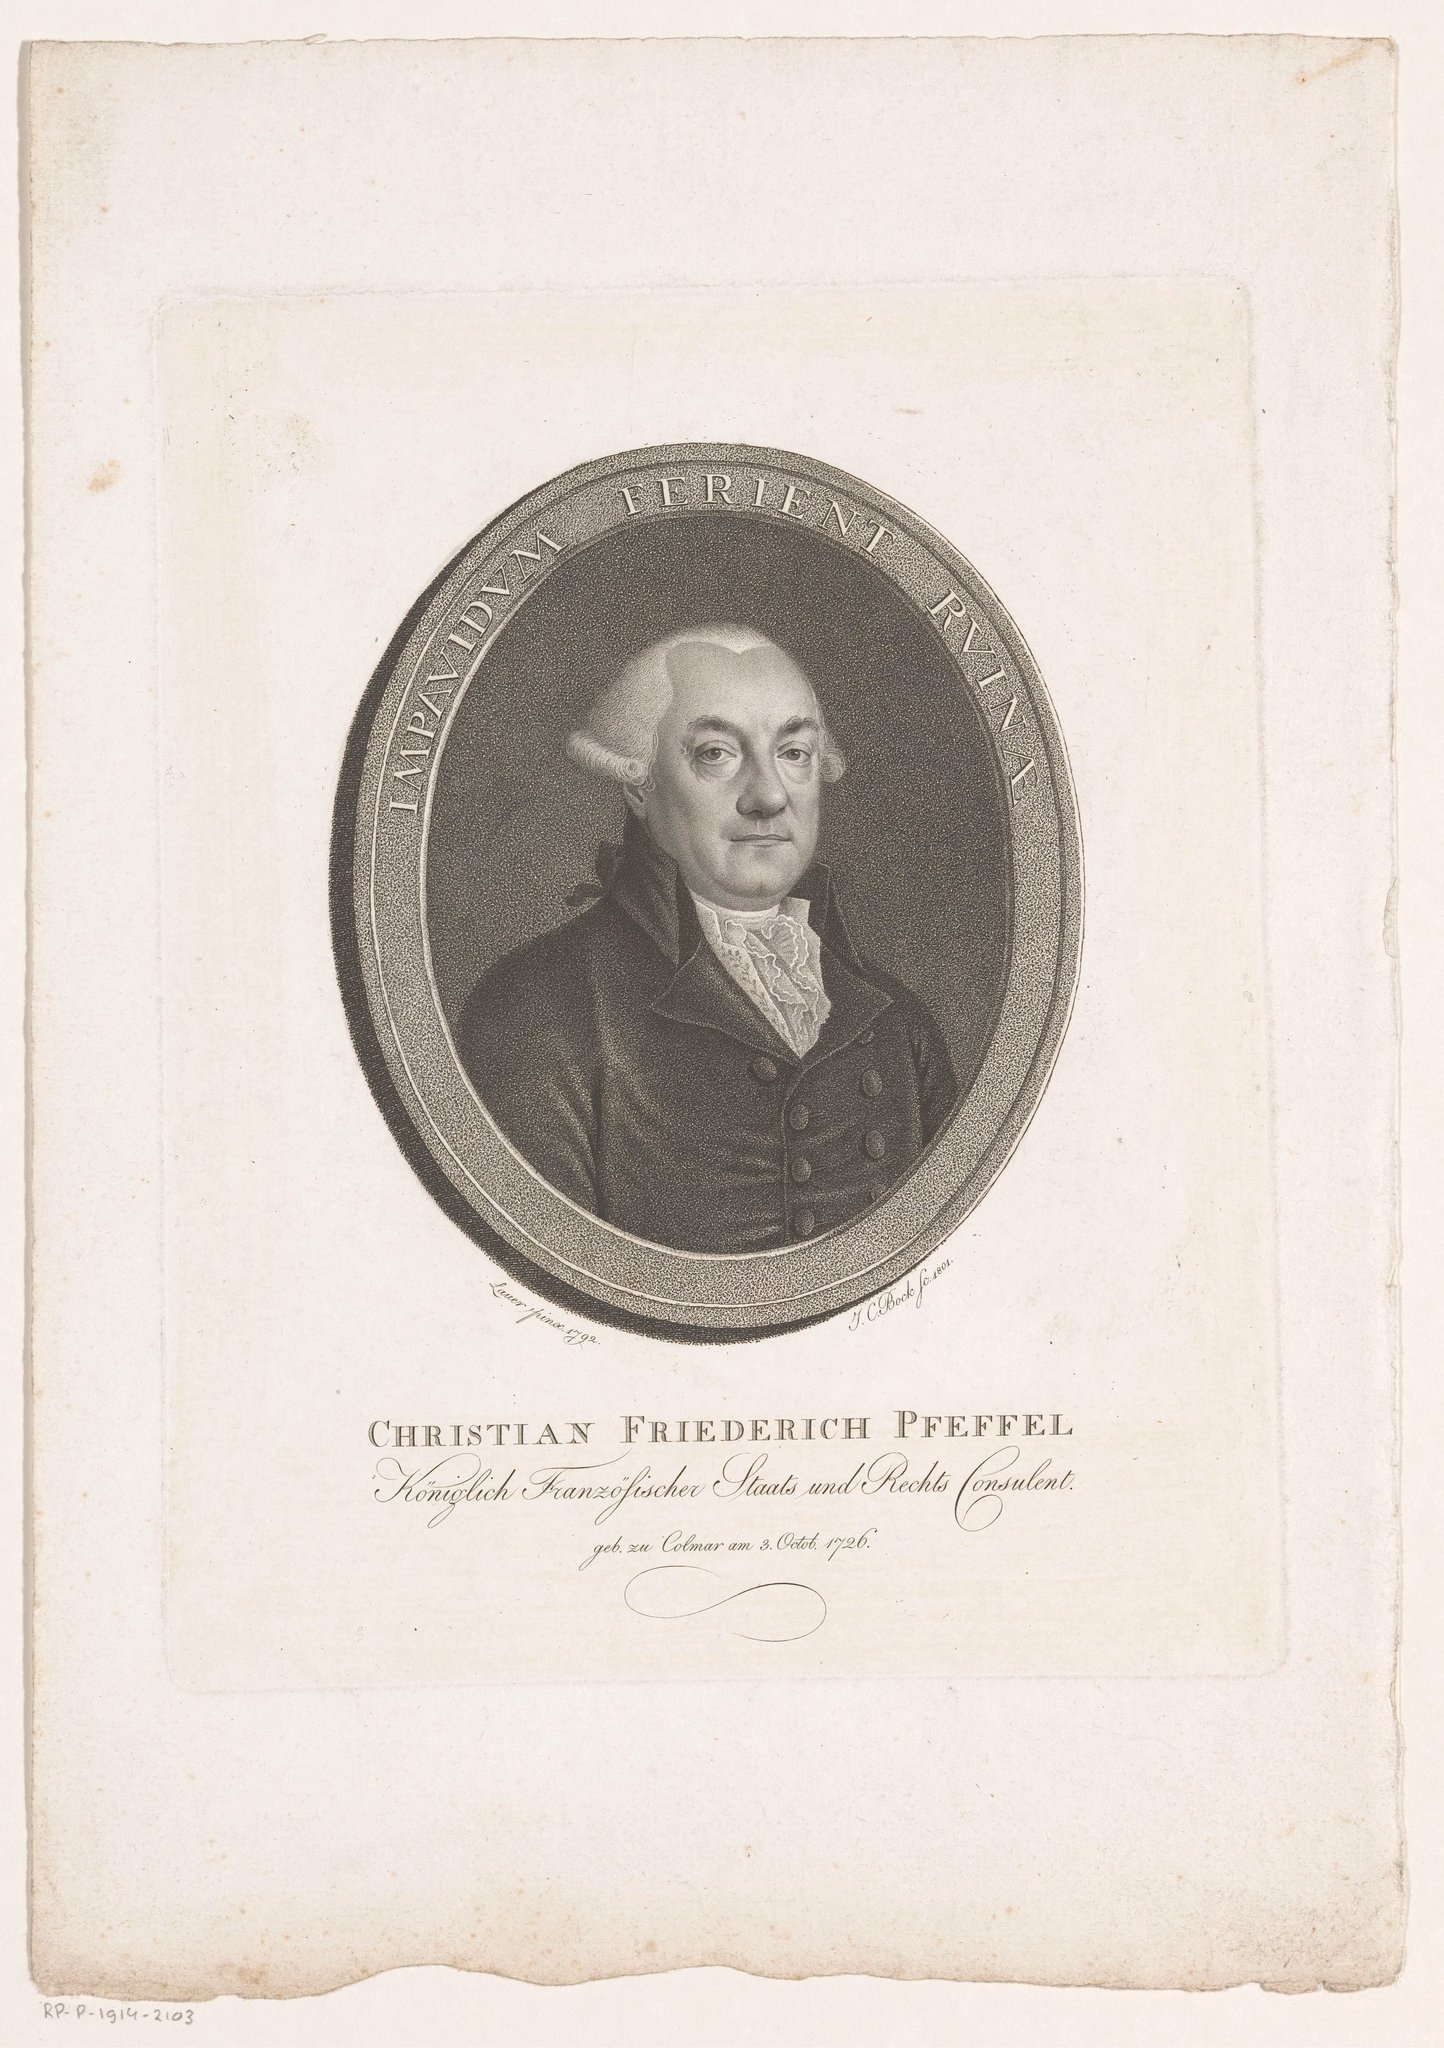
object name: print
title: Portret van Christian Friedrich Pfeffel von Kriegelstein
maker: johann carl bock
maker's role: print maker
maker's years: 1757-1843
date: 1801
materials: paper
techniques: etching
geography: nuremberg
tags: paris, historical persons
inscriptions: collector's mark: Lugt 2228